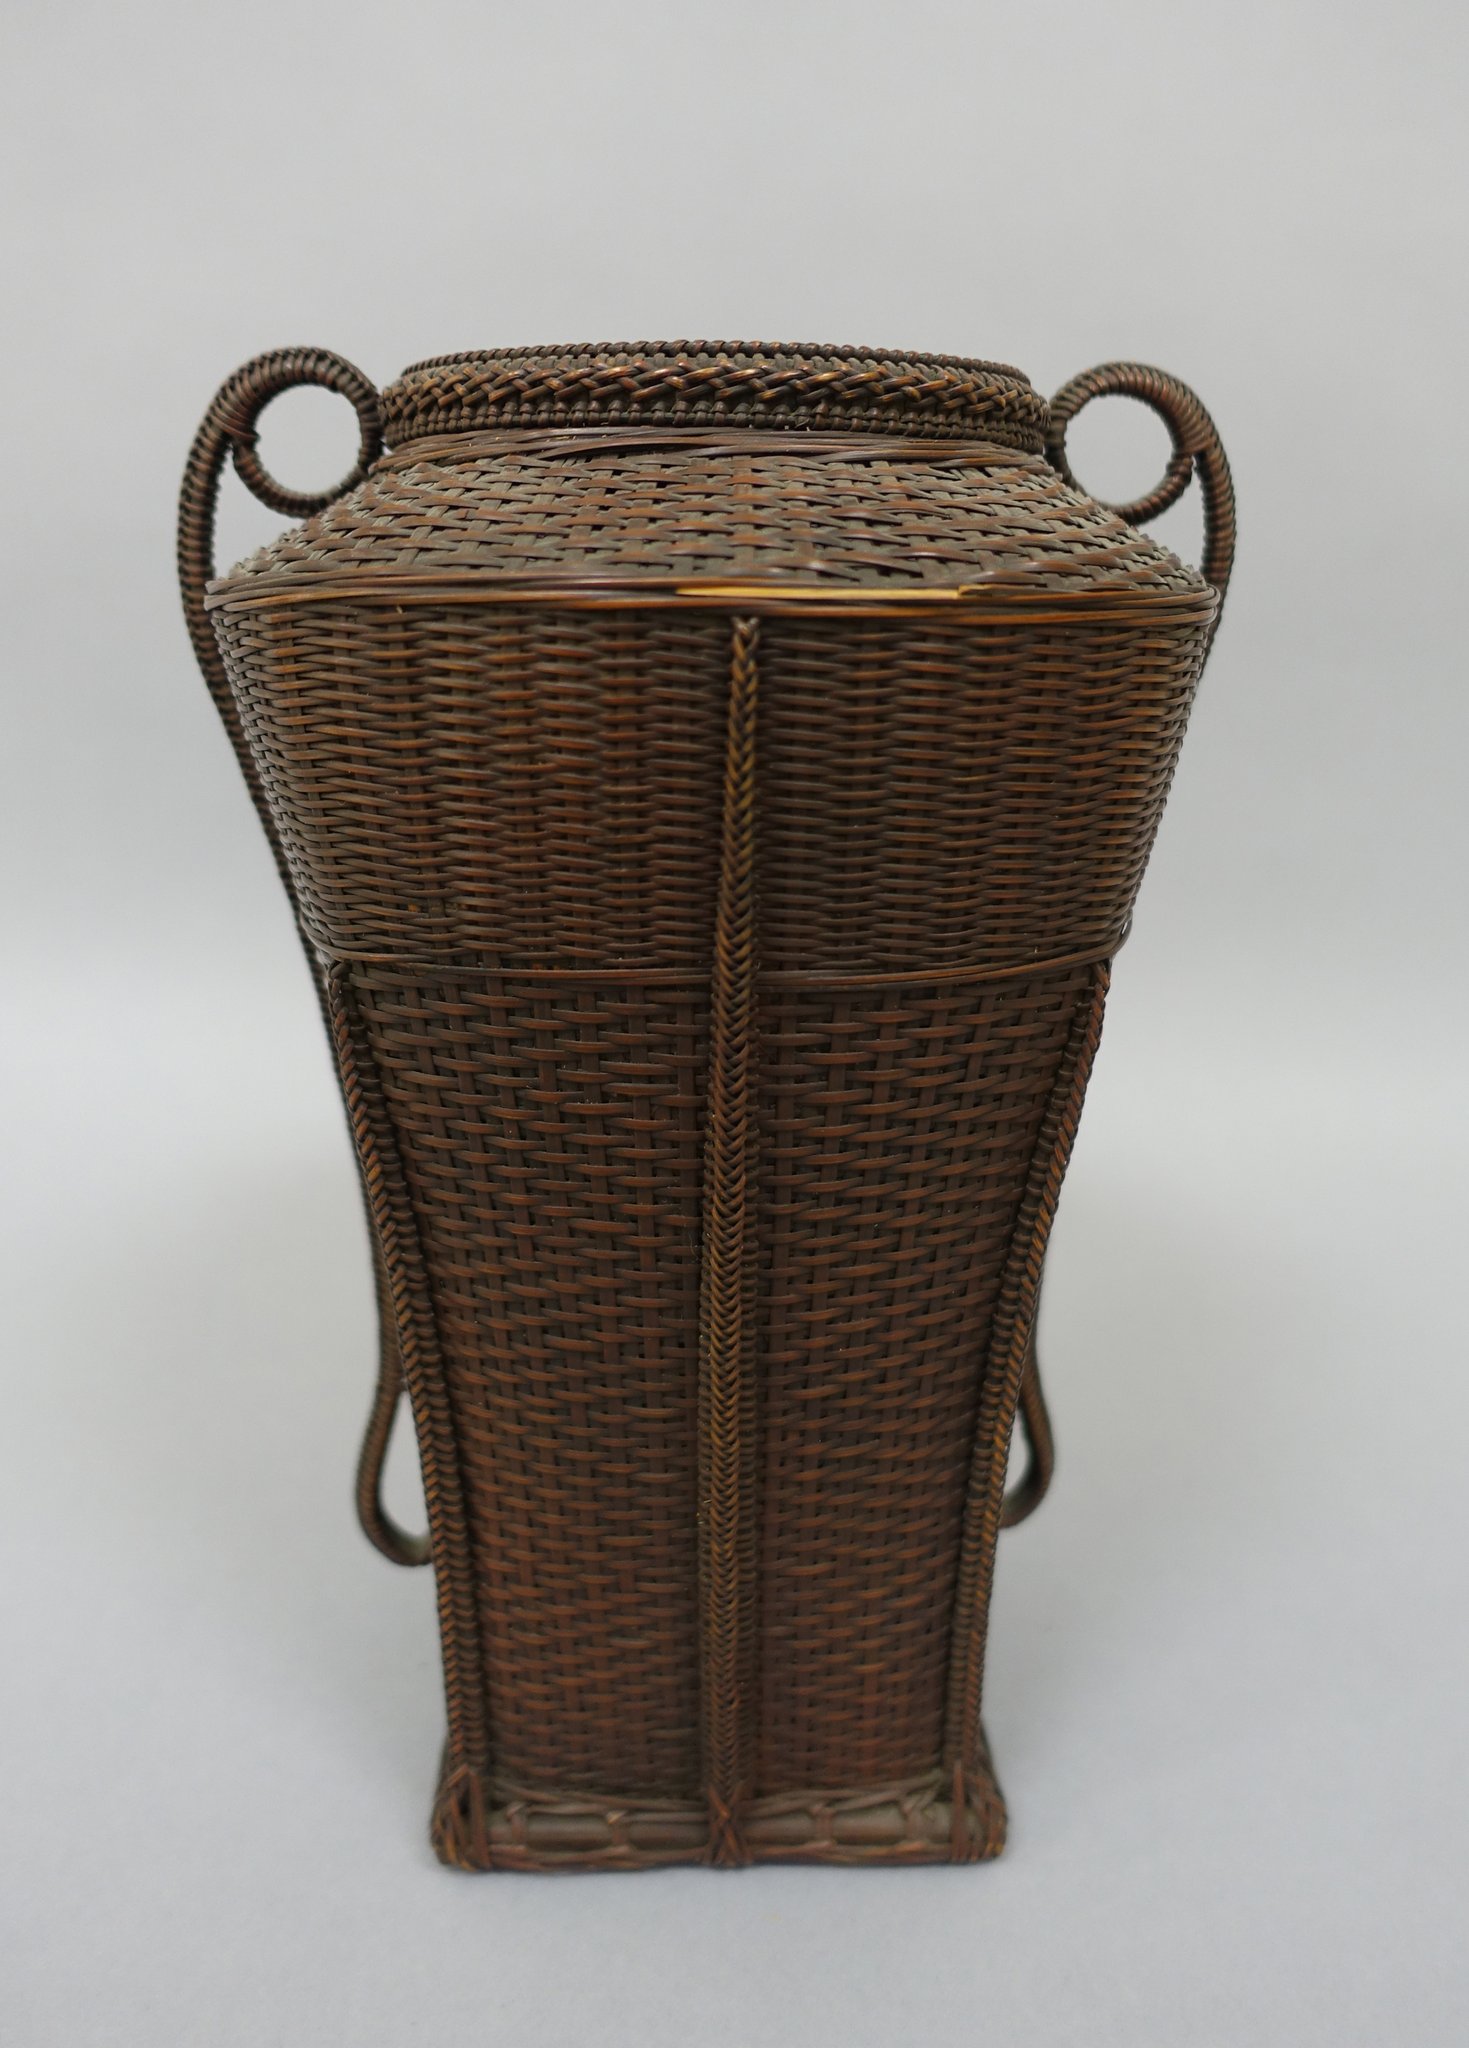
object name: basket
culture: japanese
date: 1801-1900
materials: bamboo